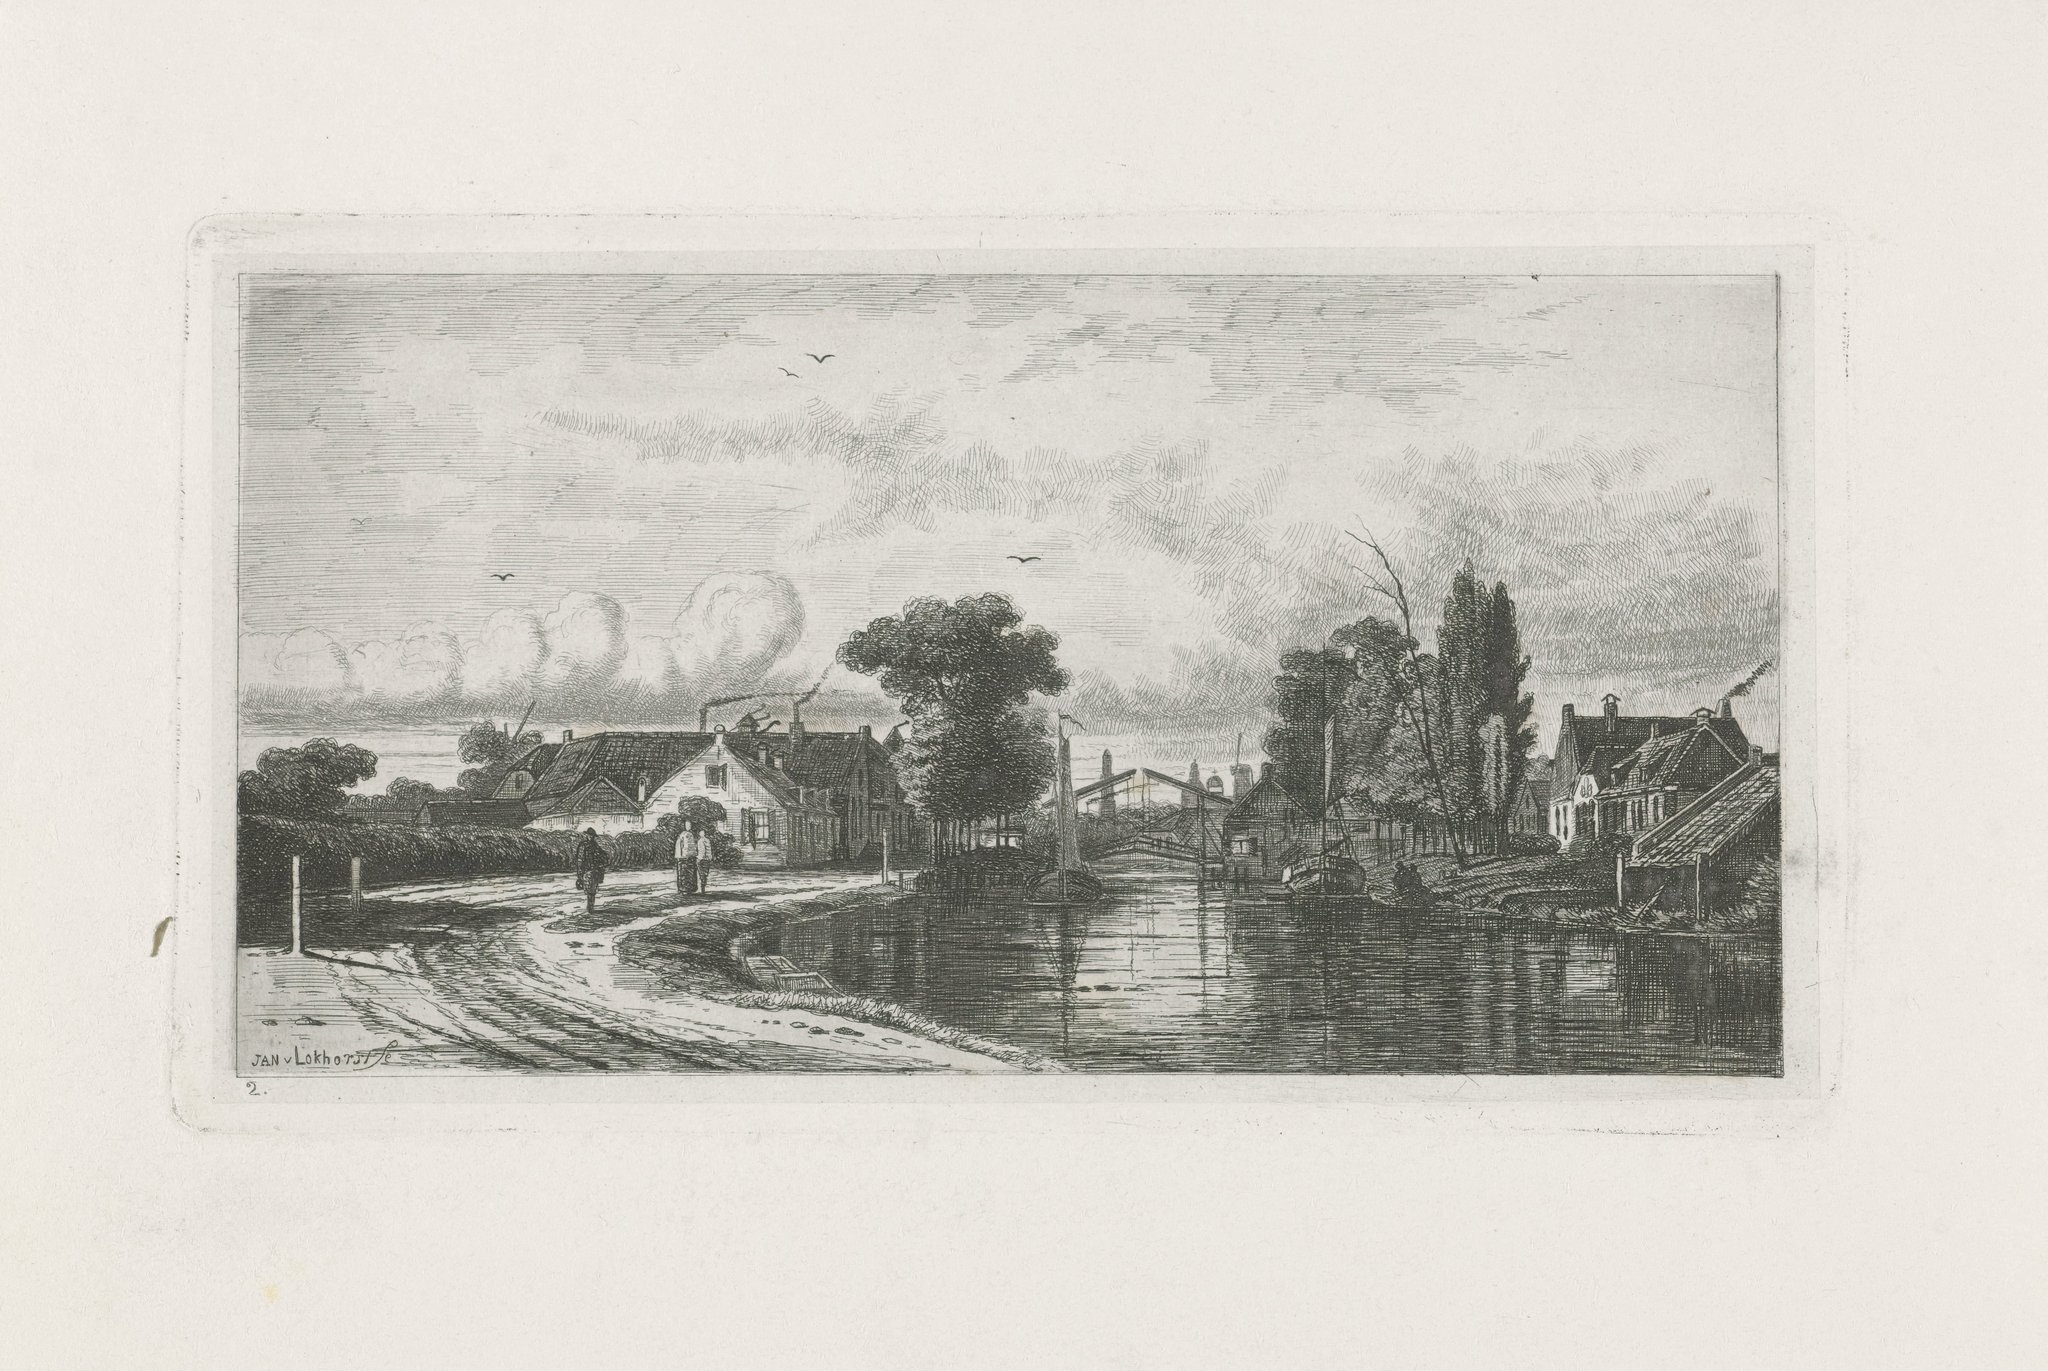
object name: print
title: Rivierlandschap met ophaalbrug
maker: jan van lokhorst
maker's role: draughtsman, print maker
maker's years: 1837-1894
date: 1858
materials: paper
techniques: etching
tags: landscapes with waters, waterscapes, seascapes (in the temperate zone)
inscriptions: collector's mark: Lugt 2228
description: Rivierlandschap met een zeilschip voor een ophaalbrug. Aan weerszijden van de rivier staan huizen, links lopen figuren langs het water.